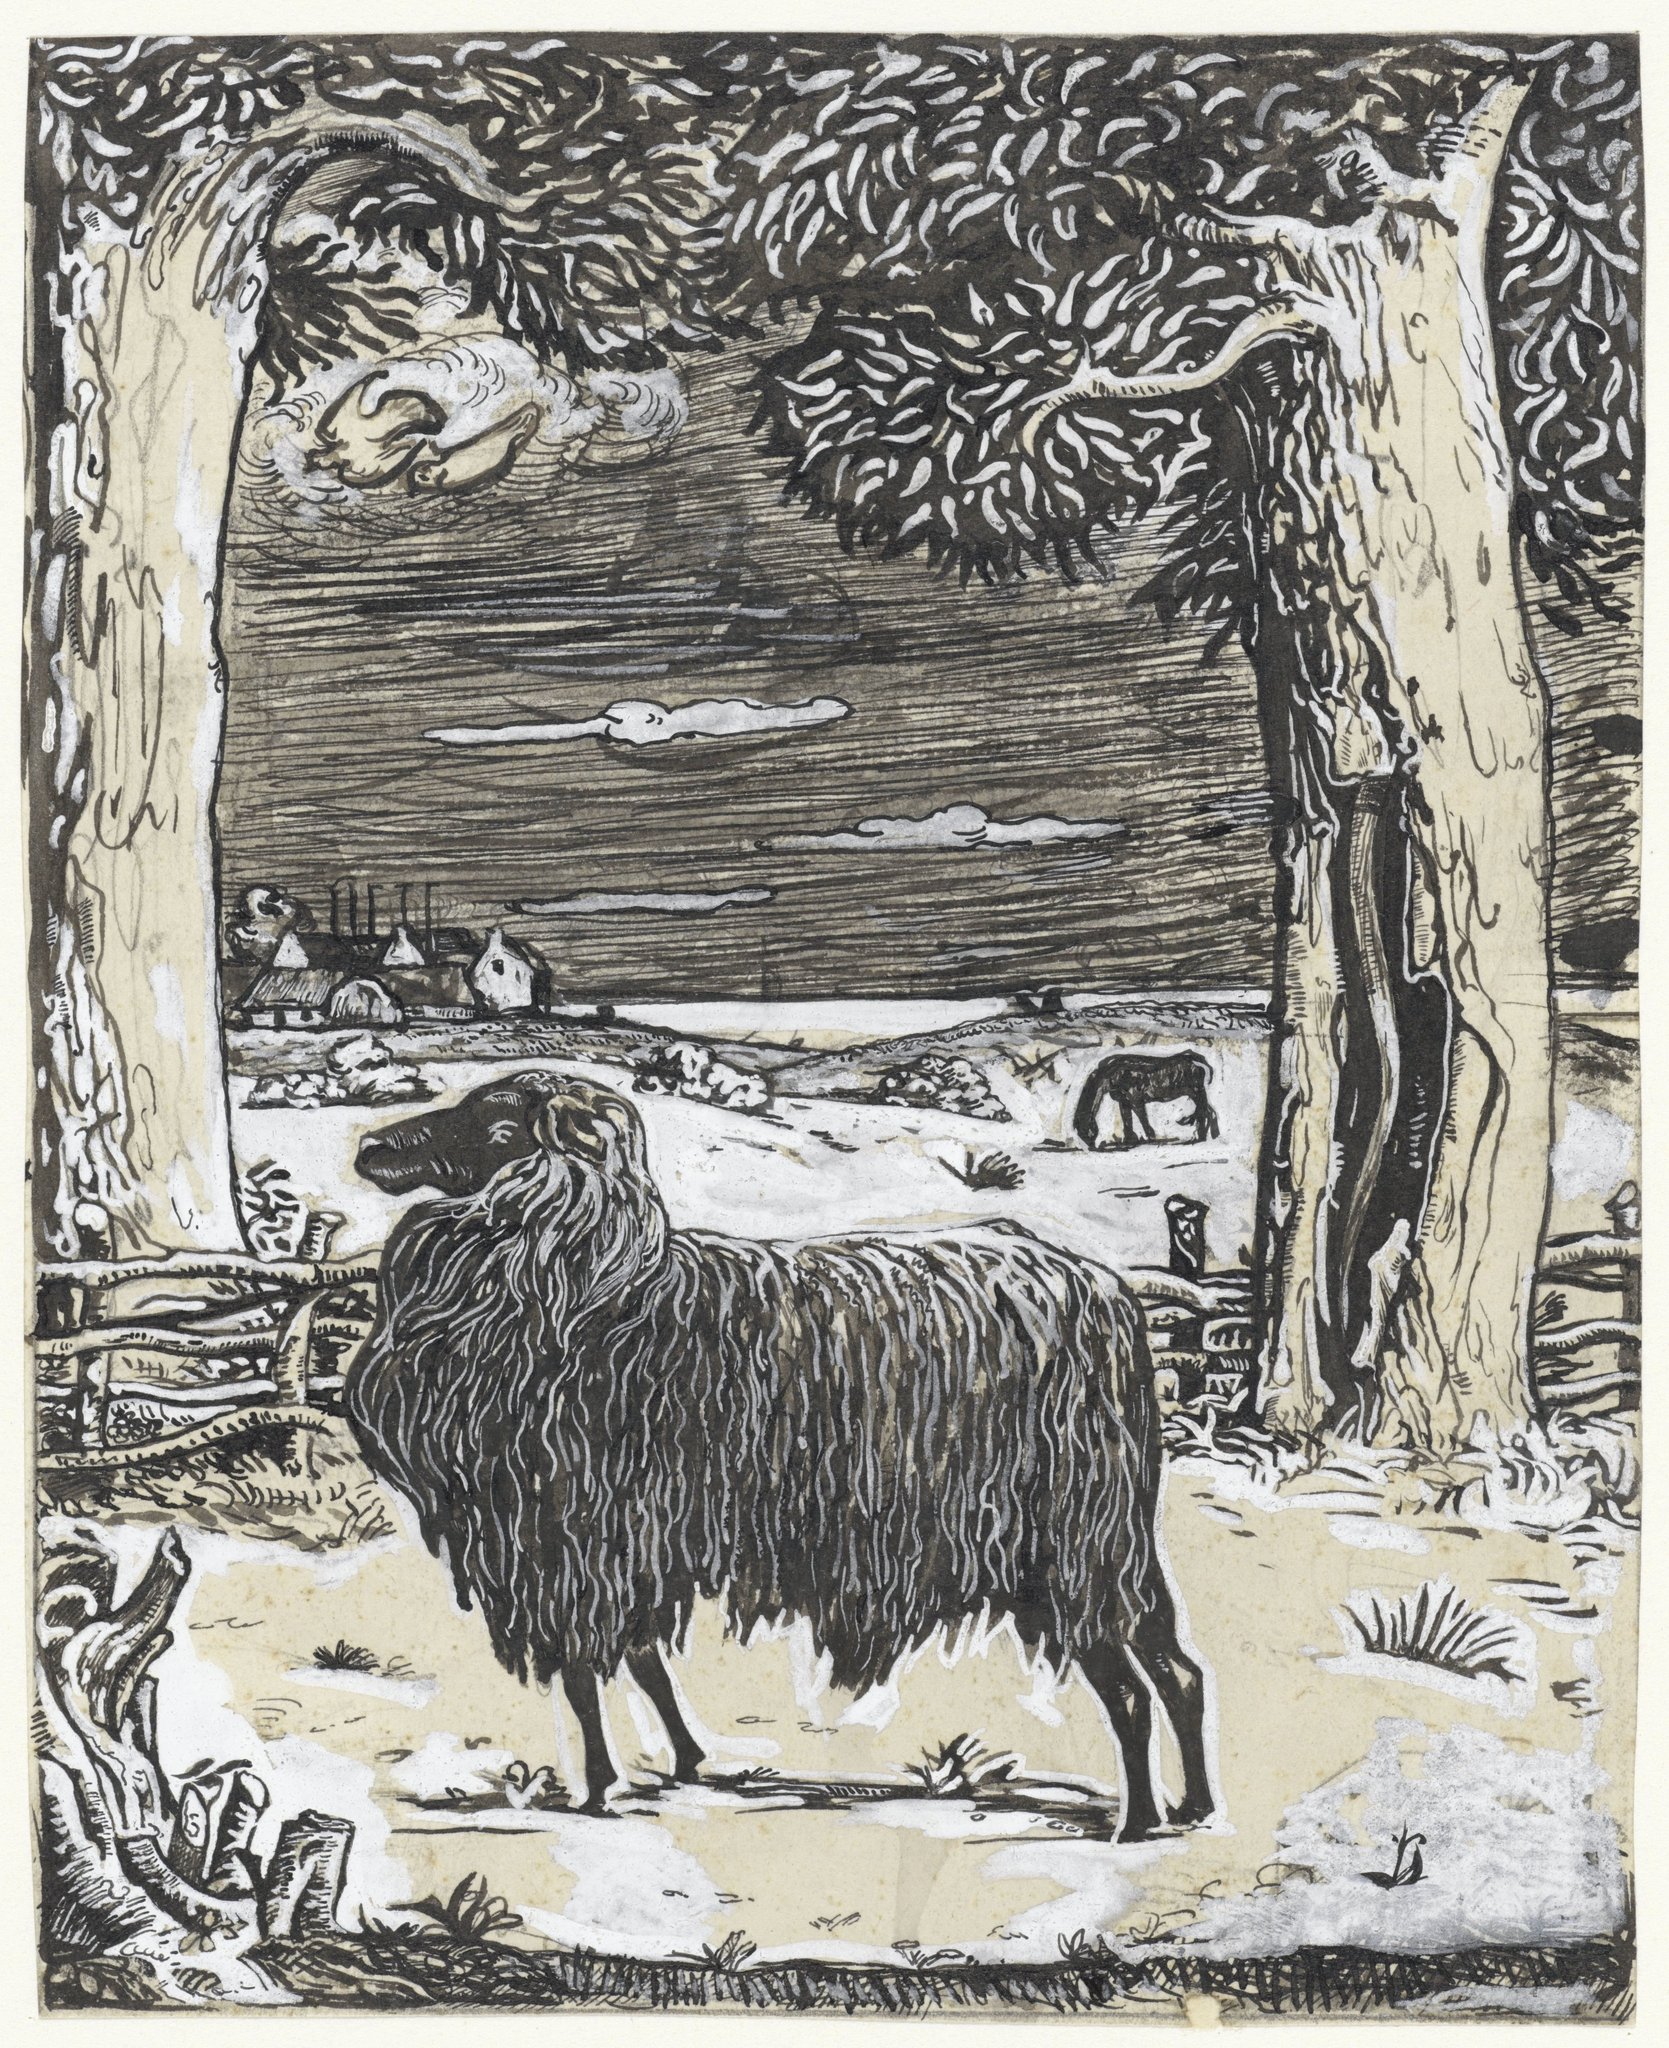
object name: drawing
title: Schaap in een landschap met twee bomen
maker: richard nicolaüs roland holst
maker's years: 1868-1938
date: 1878-1938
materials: paint, ink, paper, pencil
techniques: brush, pen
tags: sheep, coast